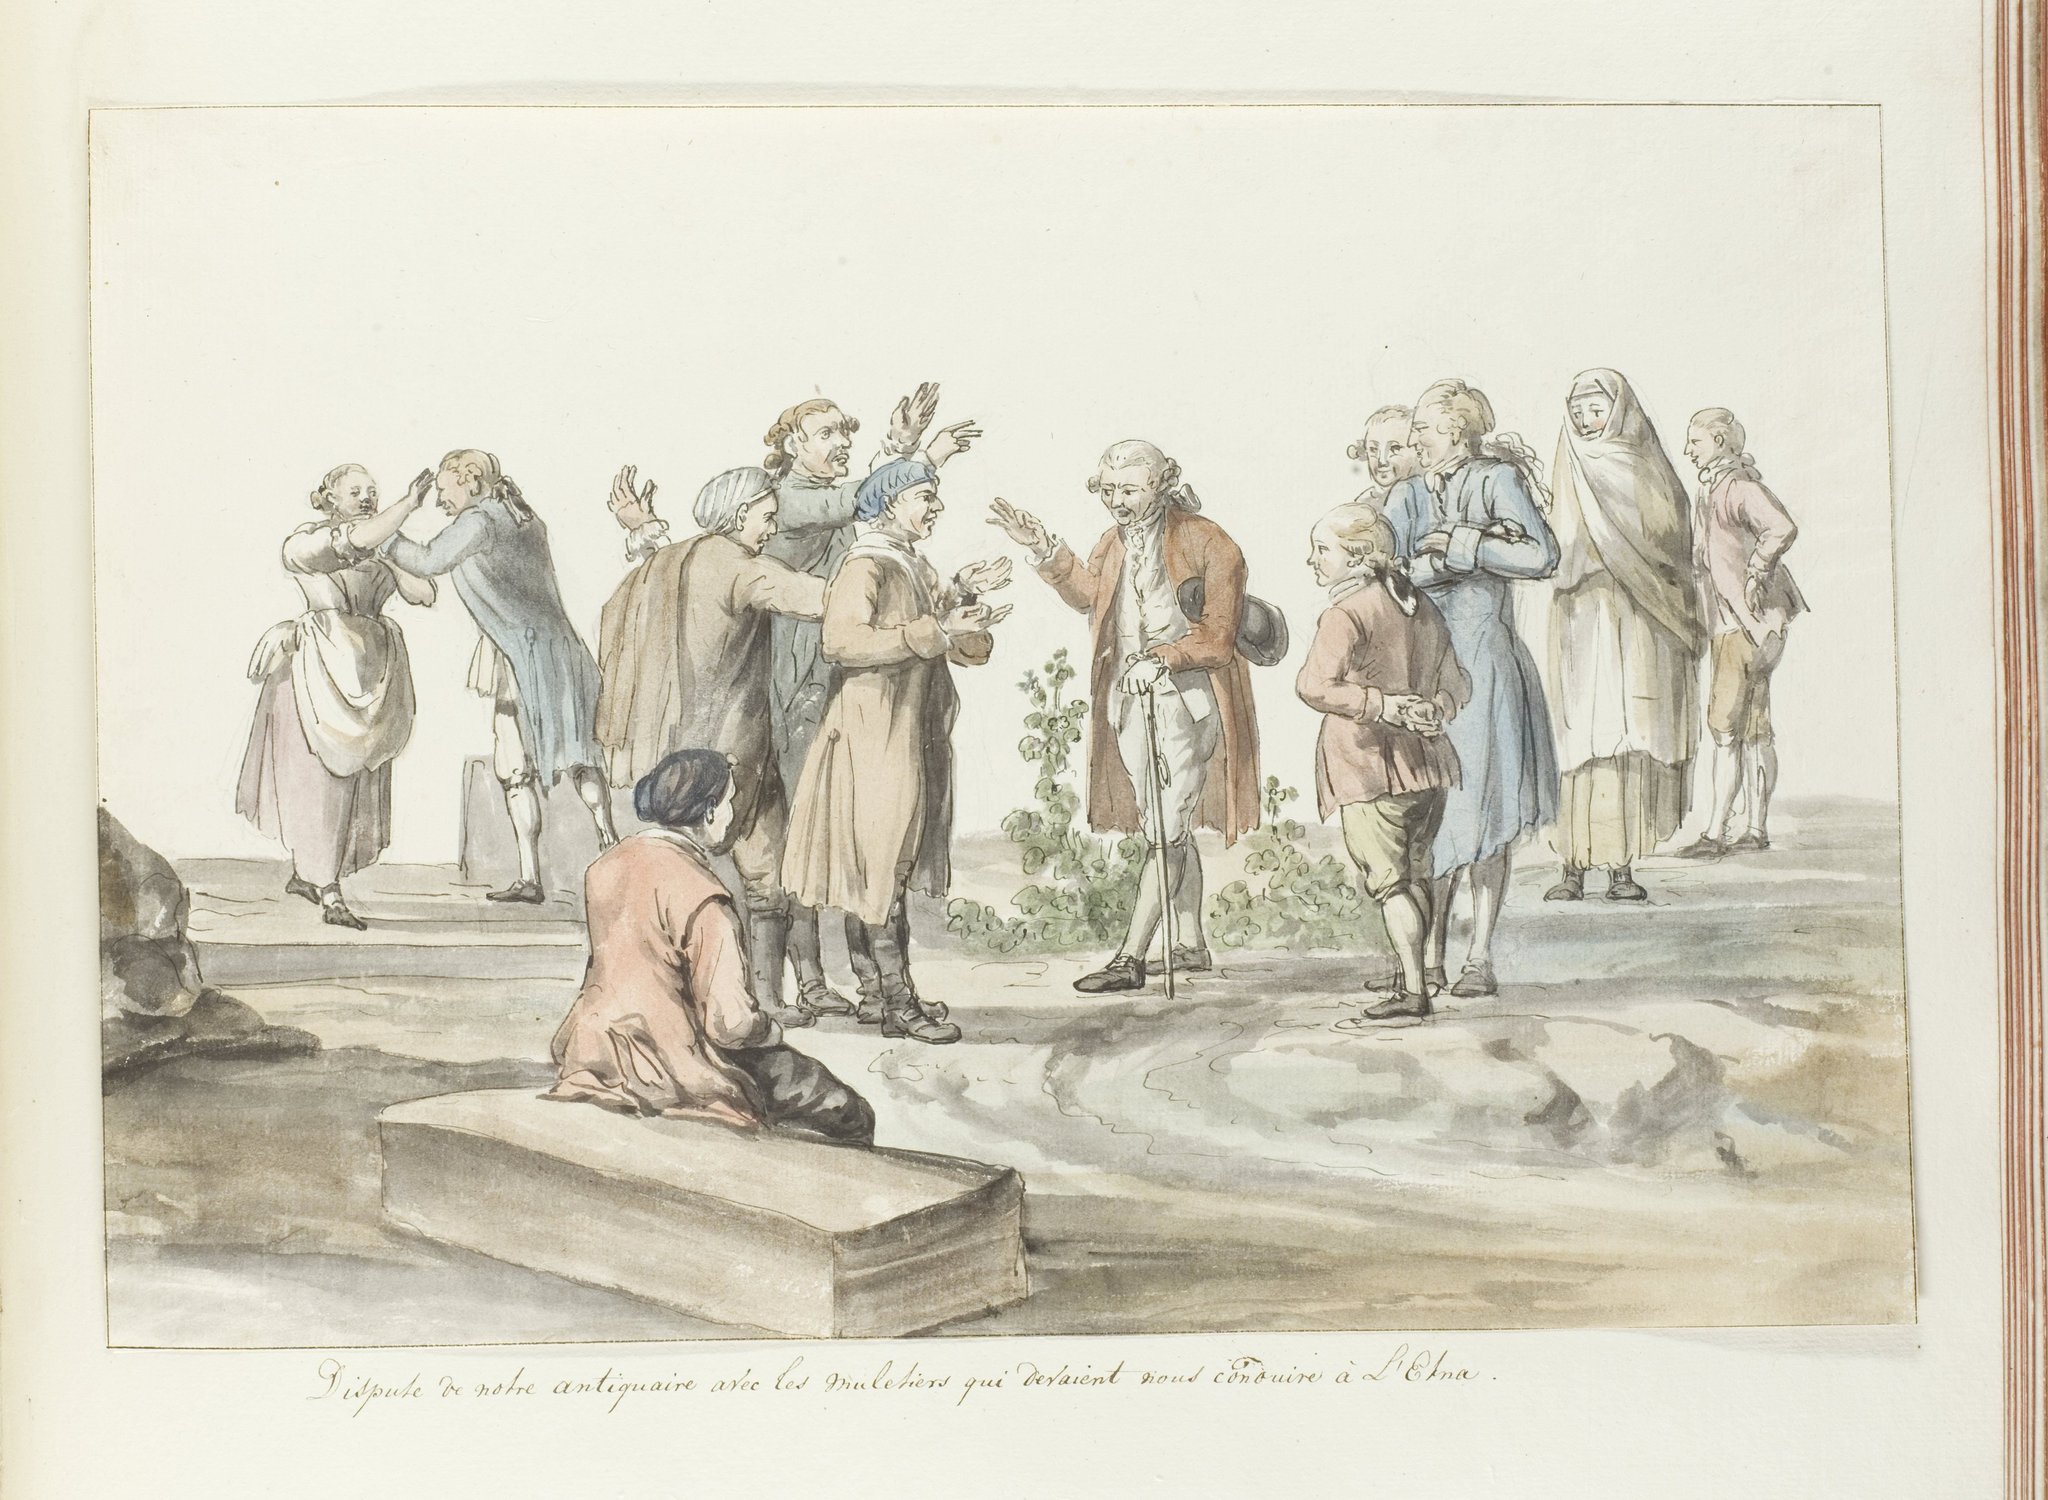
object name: drawing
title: Dispute de notre antiquaire avec les muletiers qui devaient nous conduire à L'Etna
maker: louis ducros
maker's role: draughtsman, print maker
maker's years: 1748-1810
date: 1778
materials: chalk, paper, watercolor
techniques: brush, pen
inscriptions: inscription: ‘No 172 Dispute de notre antiquaire avec les muletiers qui devaient nous conduire à L'Etna’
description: Tekening uit het album 'Voyage en Italie, en Sicile et à Malte', 1778.